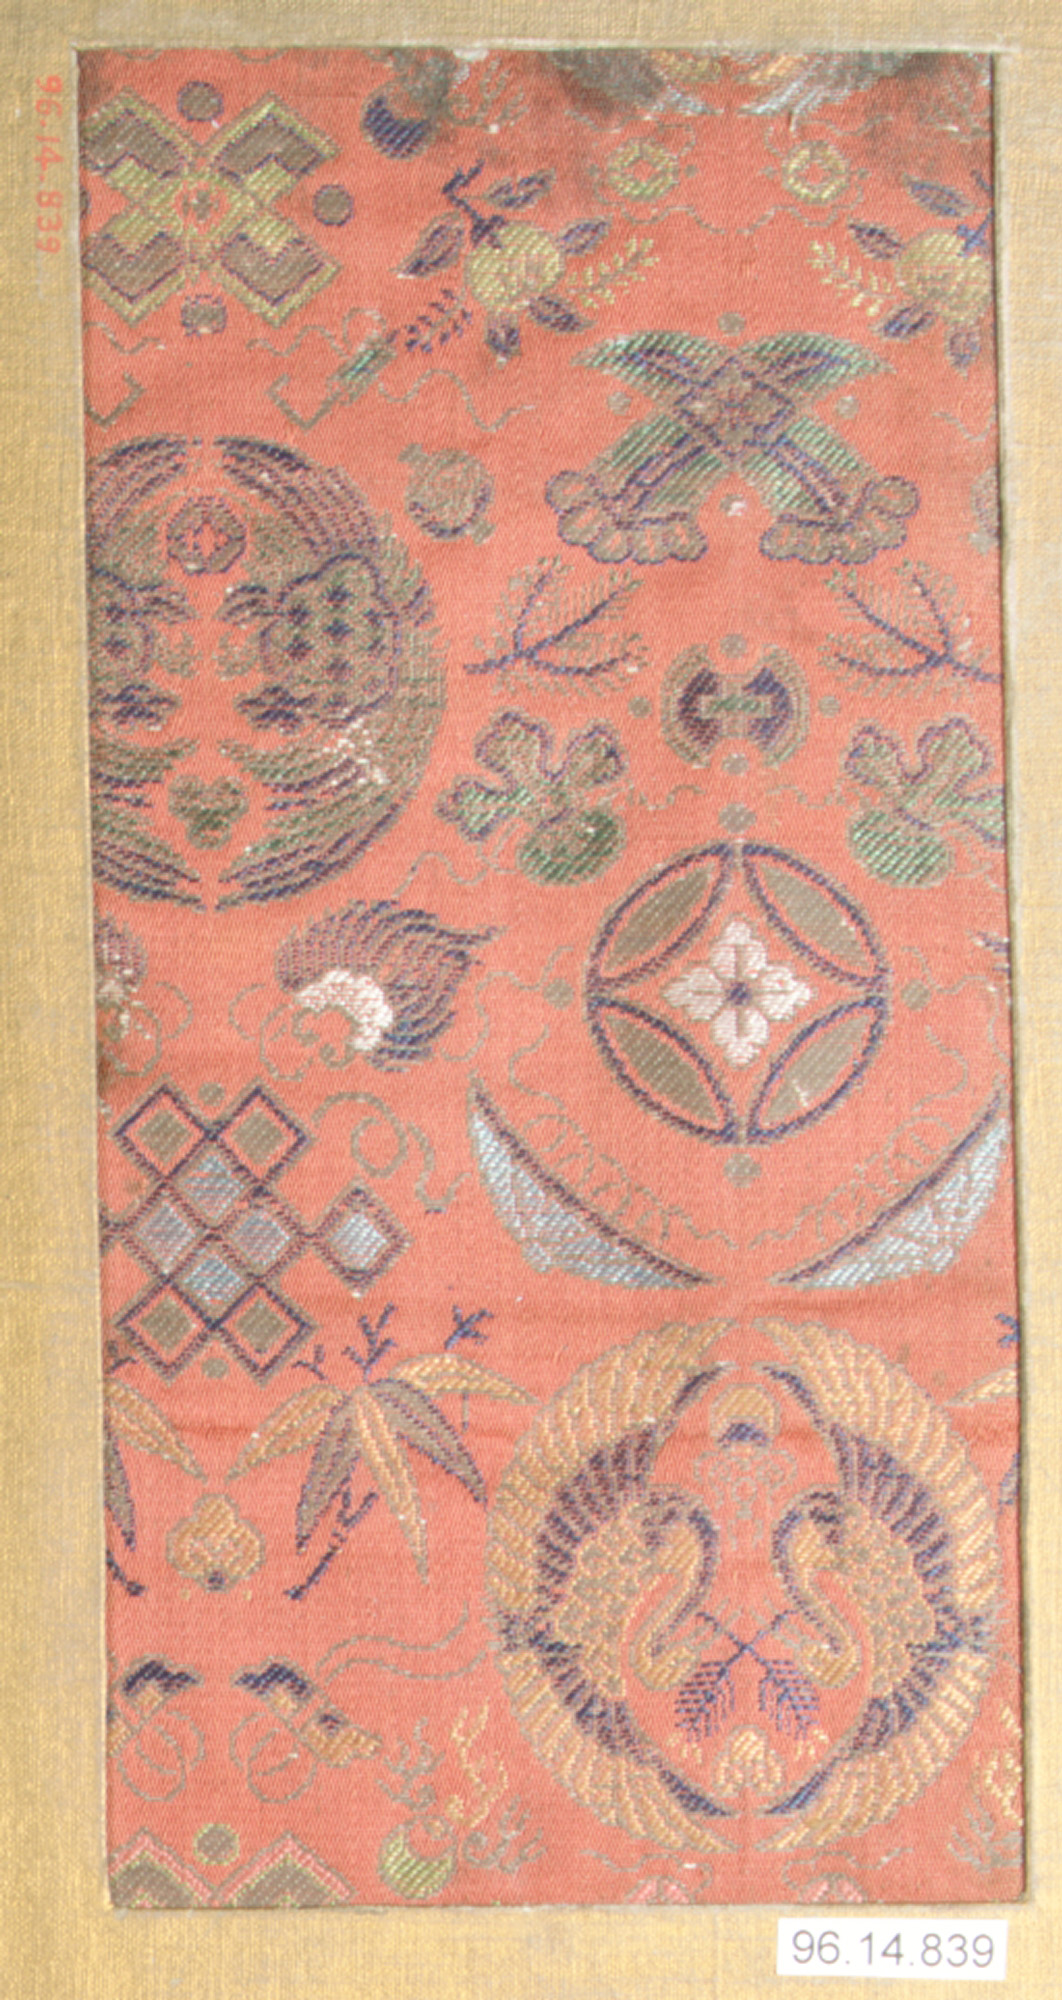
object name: piece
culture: japanese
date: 1701-1900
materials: silk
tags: cranes